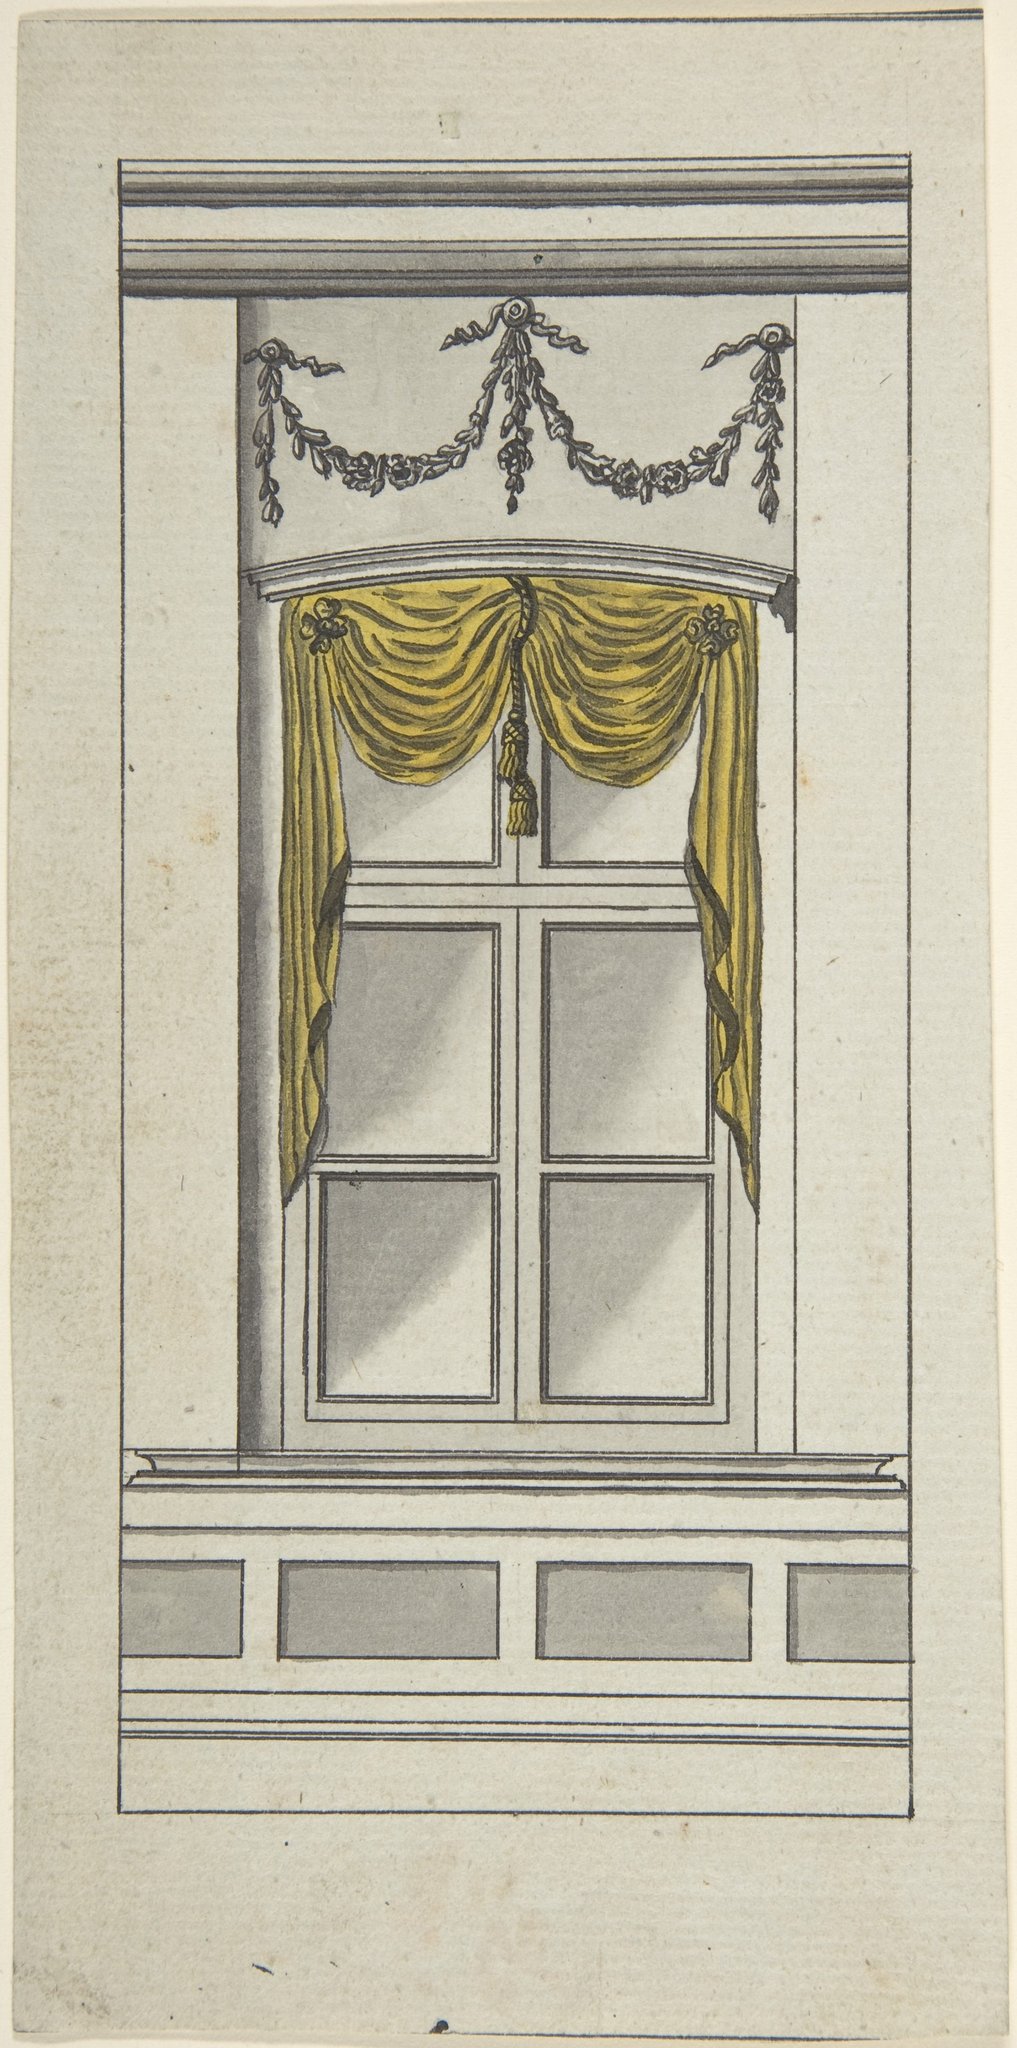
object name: drawing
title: Design for a Window with Yellow Drapery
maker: anonymous, german, 18th century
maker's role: artist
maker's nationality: german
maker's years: 1700-1800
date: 1701-1800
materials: ink, watercolor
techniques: wash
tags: windows